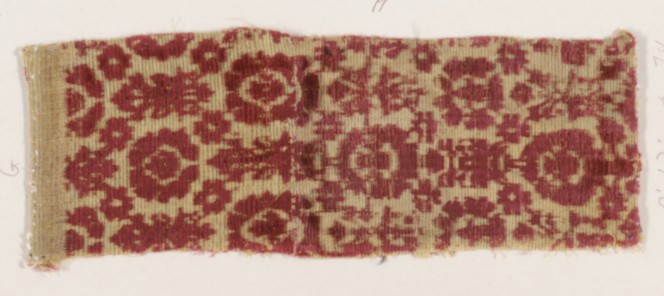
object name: fragment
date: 1701-1800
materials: metal thread, silk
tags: flowers